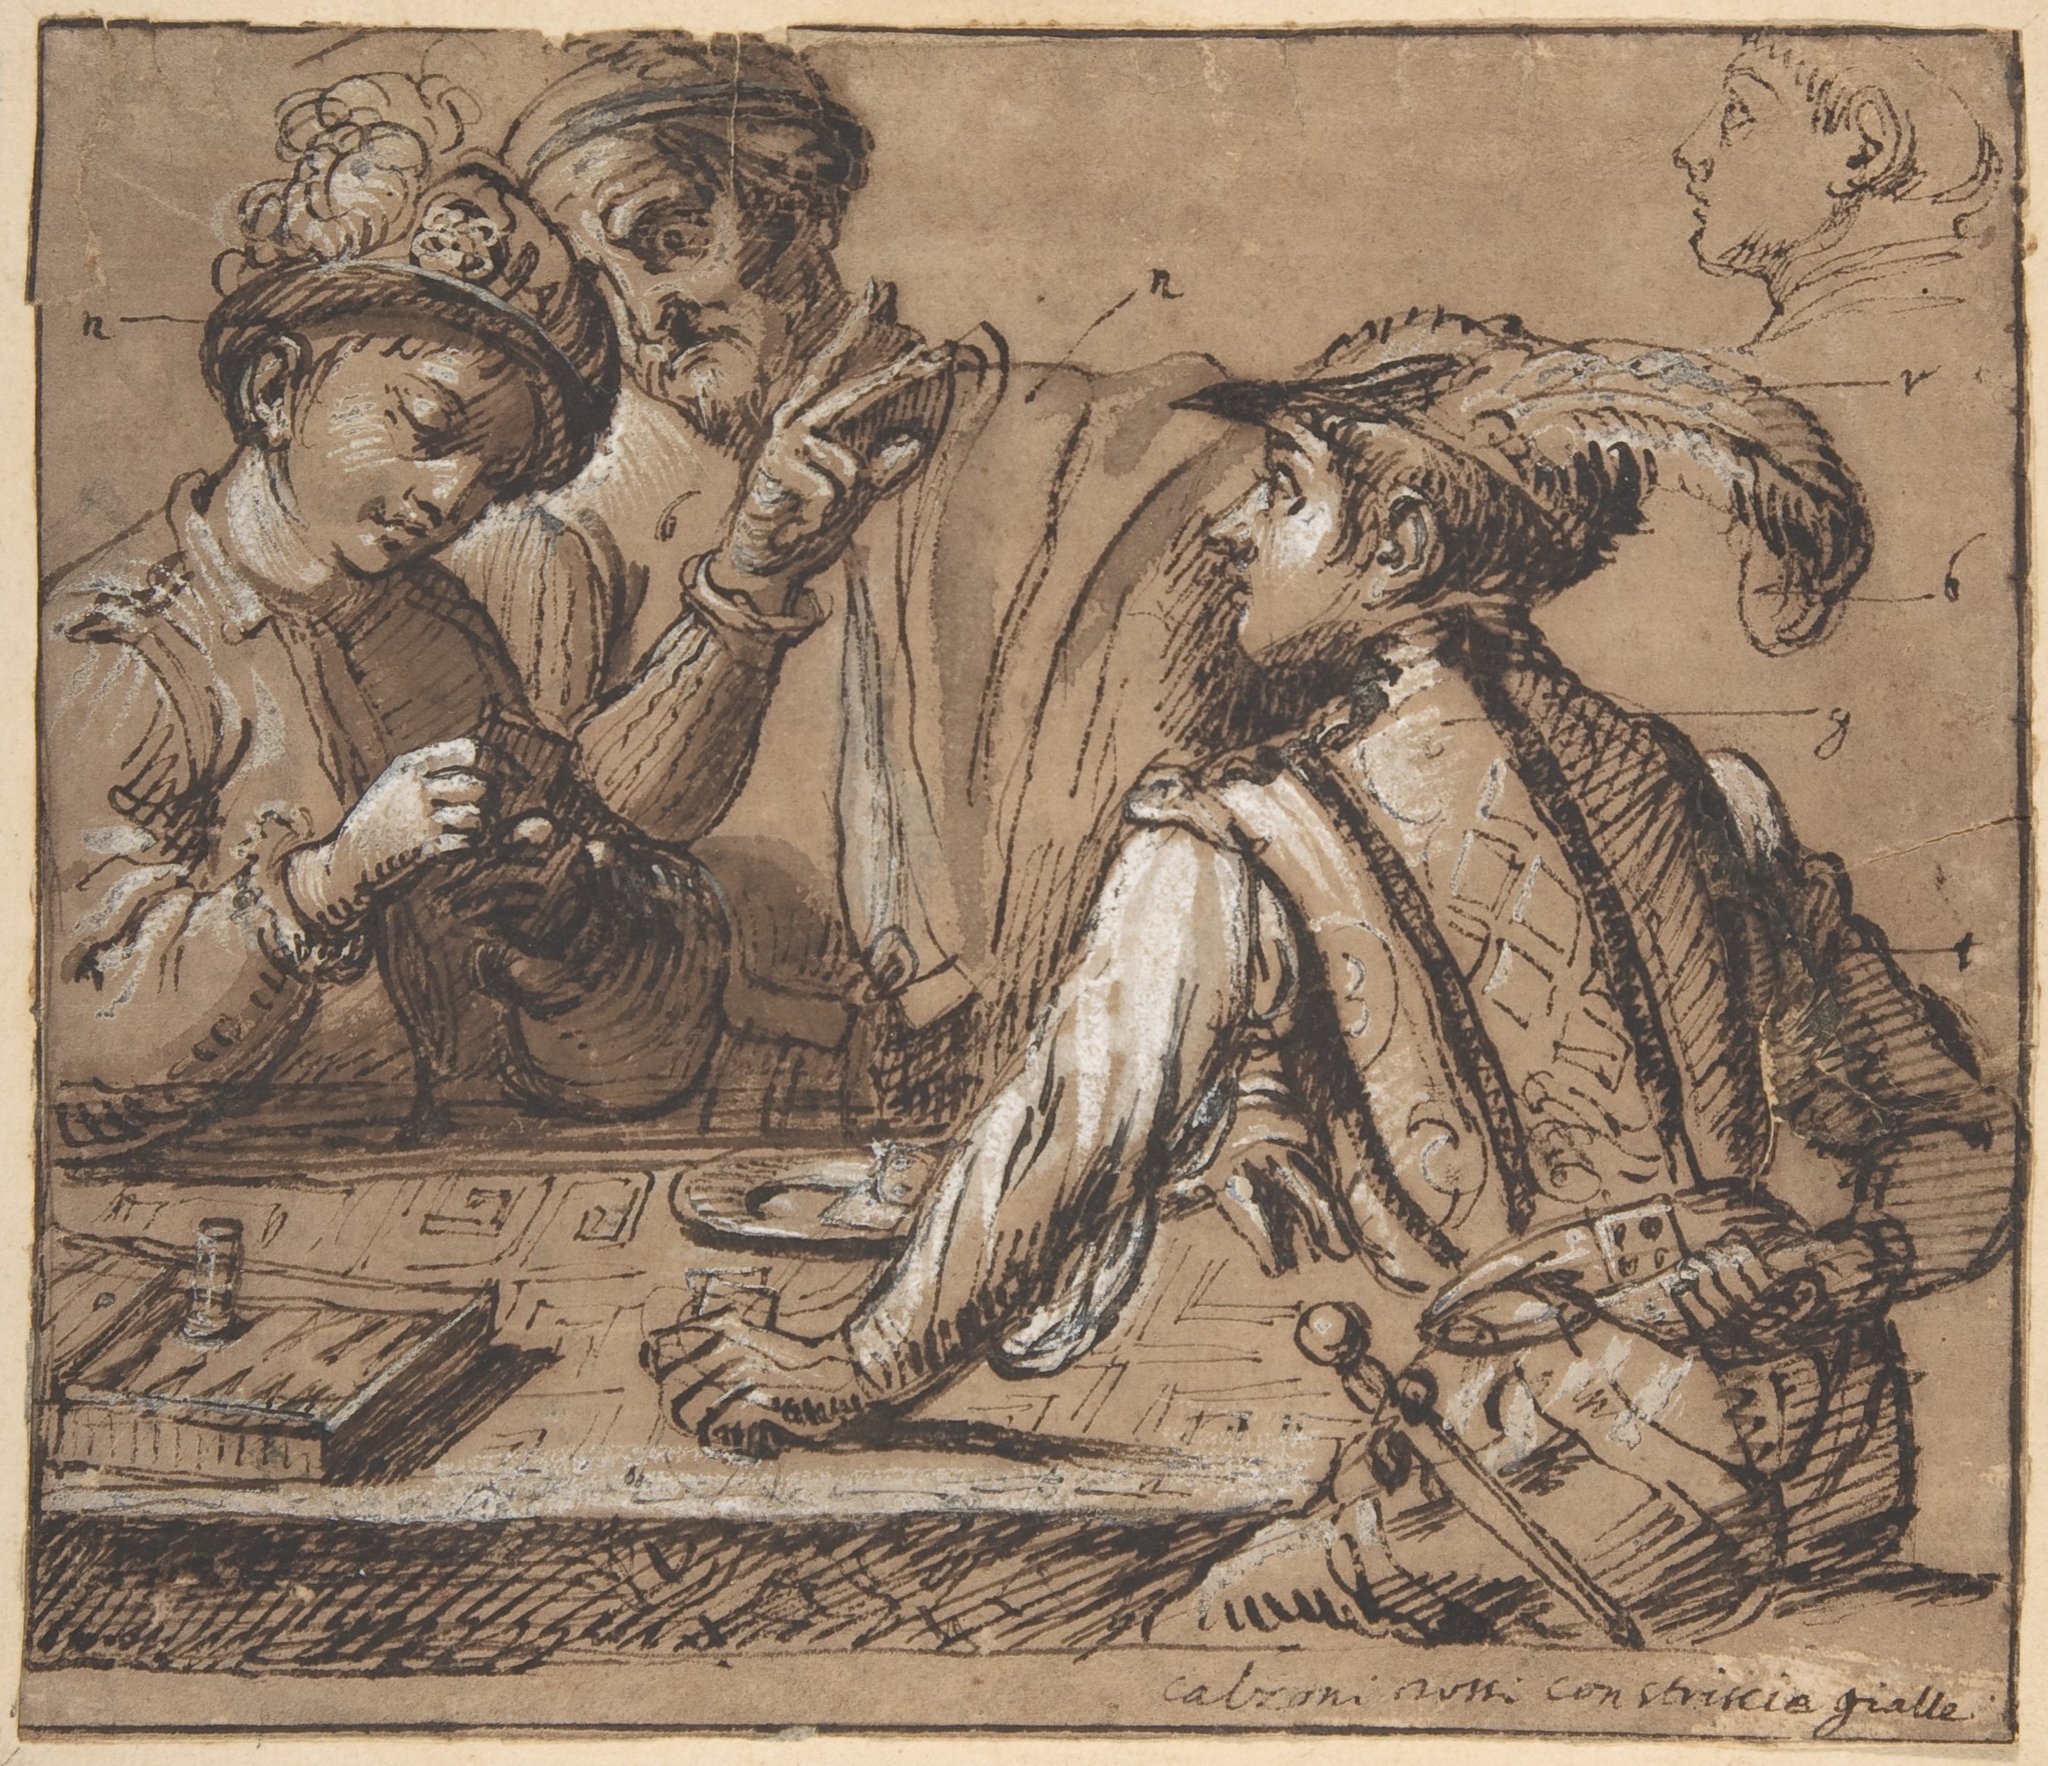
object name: drawing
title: Study after Caravaggio's 'The Cardsharps' with color notes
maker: anonymous, italian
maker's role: artist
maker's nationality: italian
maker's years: 1400-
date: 1600-1700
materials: ink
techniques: brush, heightening, pen, wash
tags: men,women